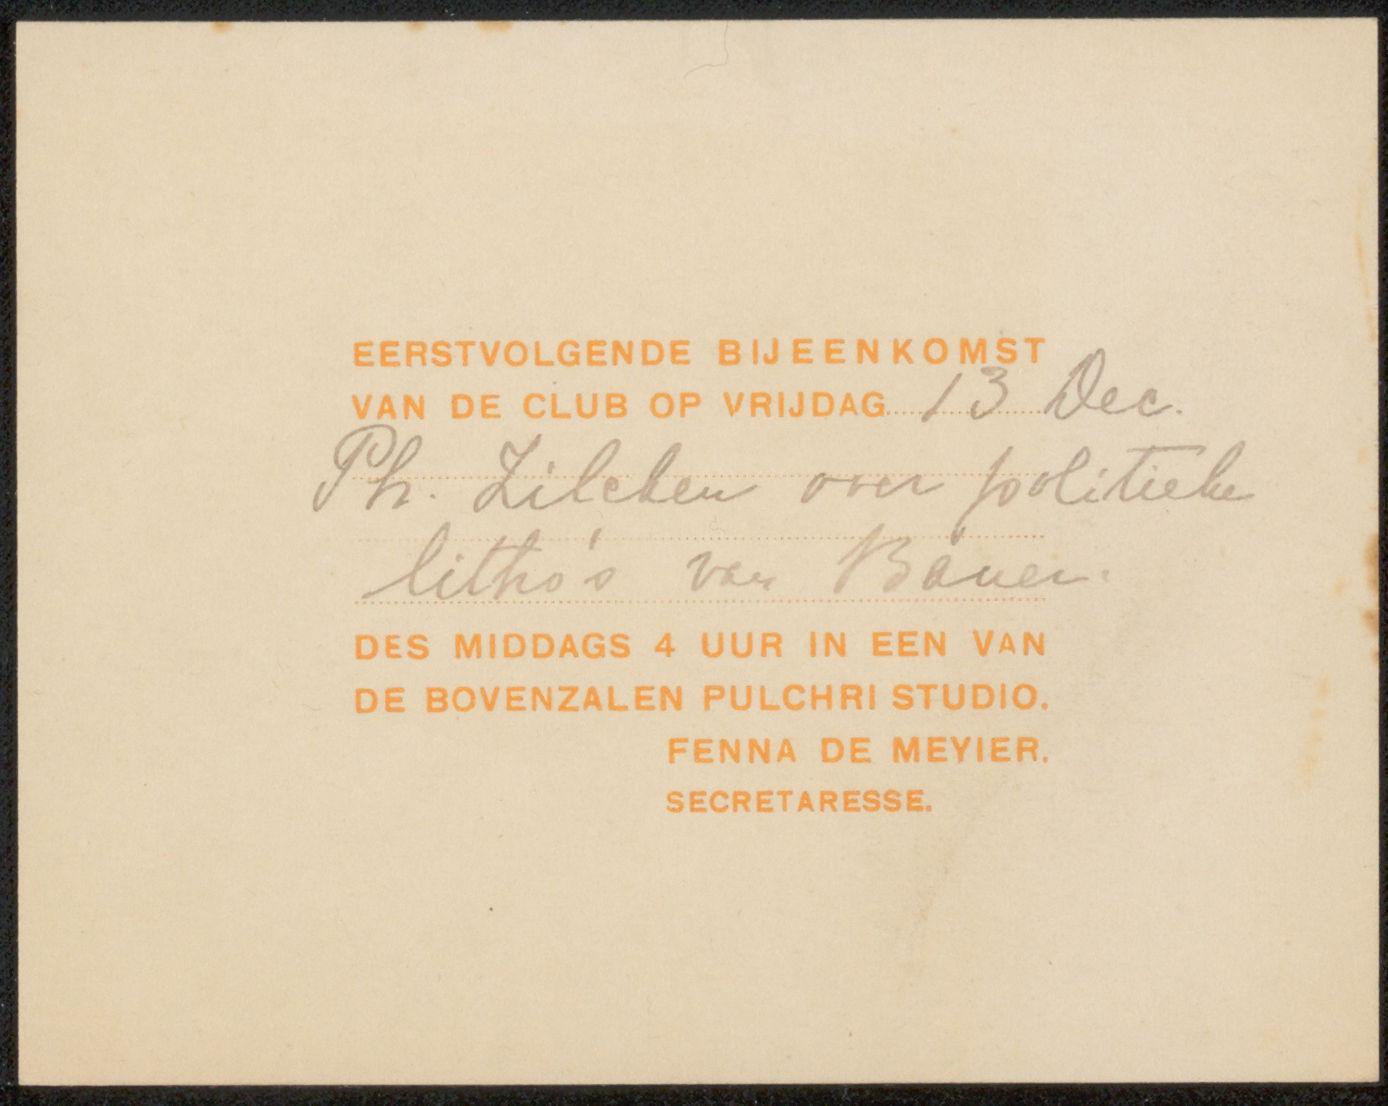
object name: invitation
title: Uitnodiging aan Philip Zilcken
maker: fenna de meyier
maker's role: onderwijzer, schrijver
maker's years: 1874-1943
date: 1884-1930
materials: cardboard, pencil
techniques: printing, writing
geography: the hague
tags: print maker, marius bauer, the hague, painter, draughtsman, philip zilcken, criticizing and discussing art, art criticism, the graphic arts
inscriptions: collector's mark: ‘RPK’